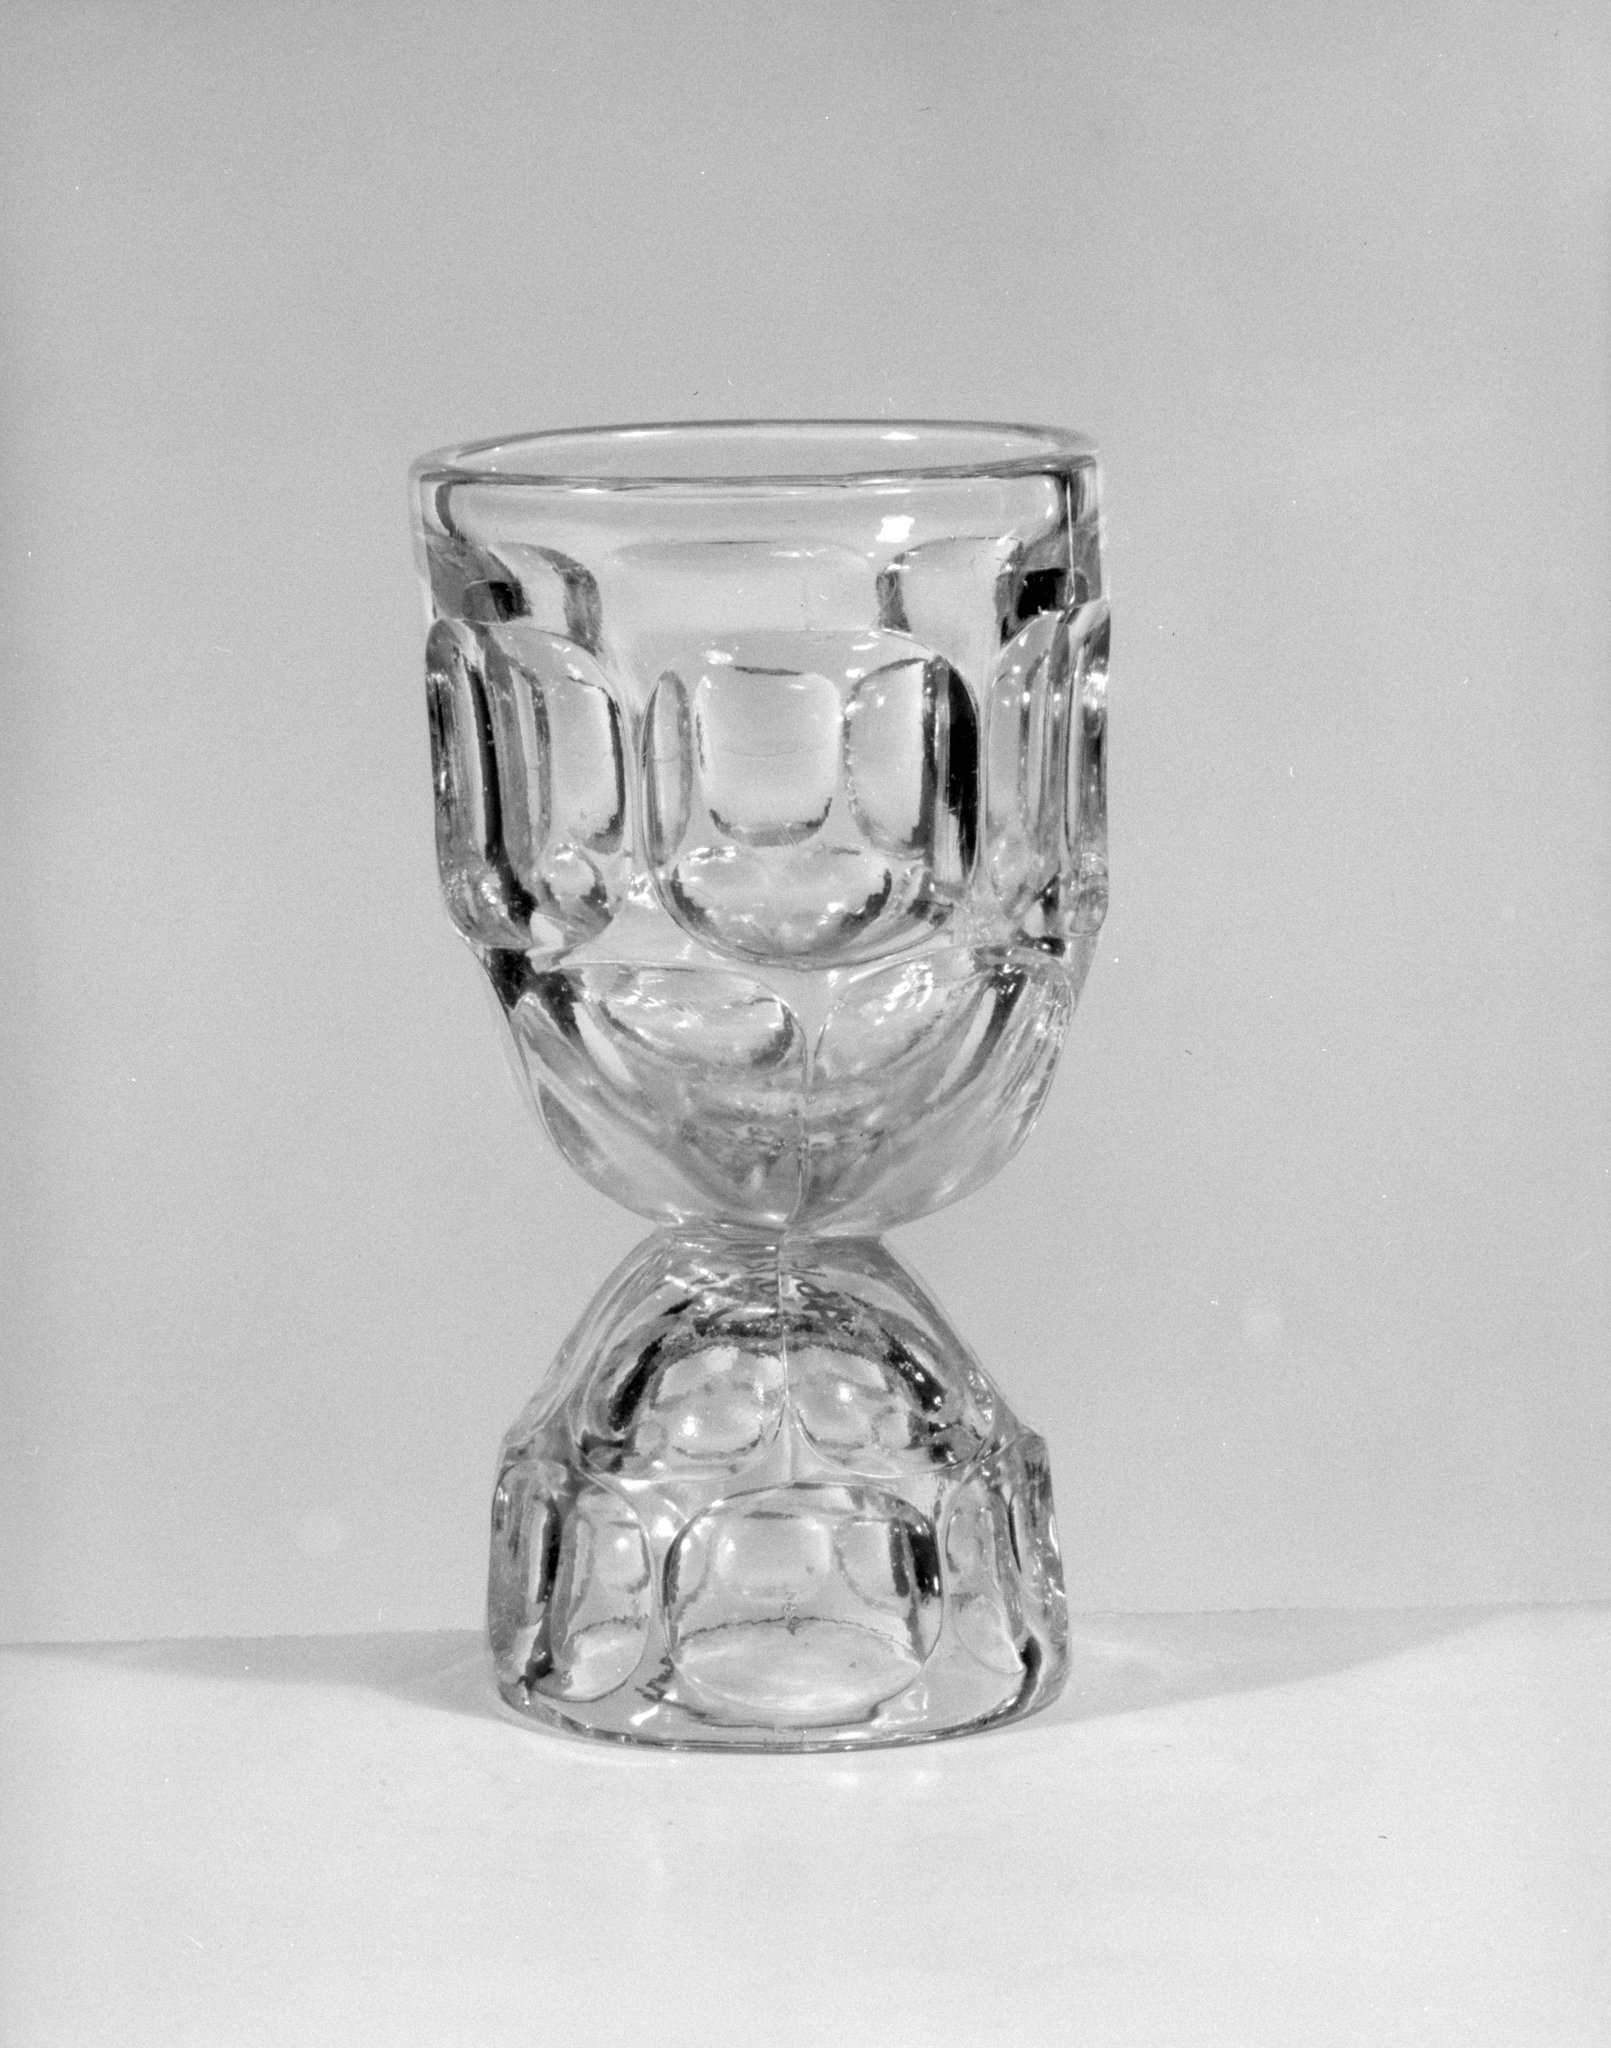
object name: egg cup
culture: american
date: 1830-1870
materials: glass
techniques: pressed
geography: united states